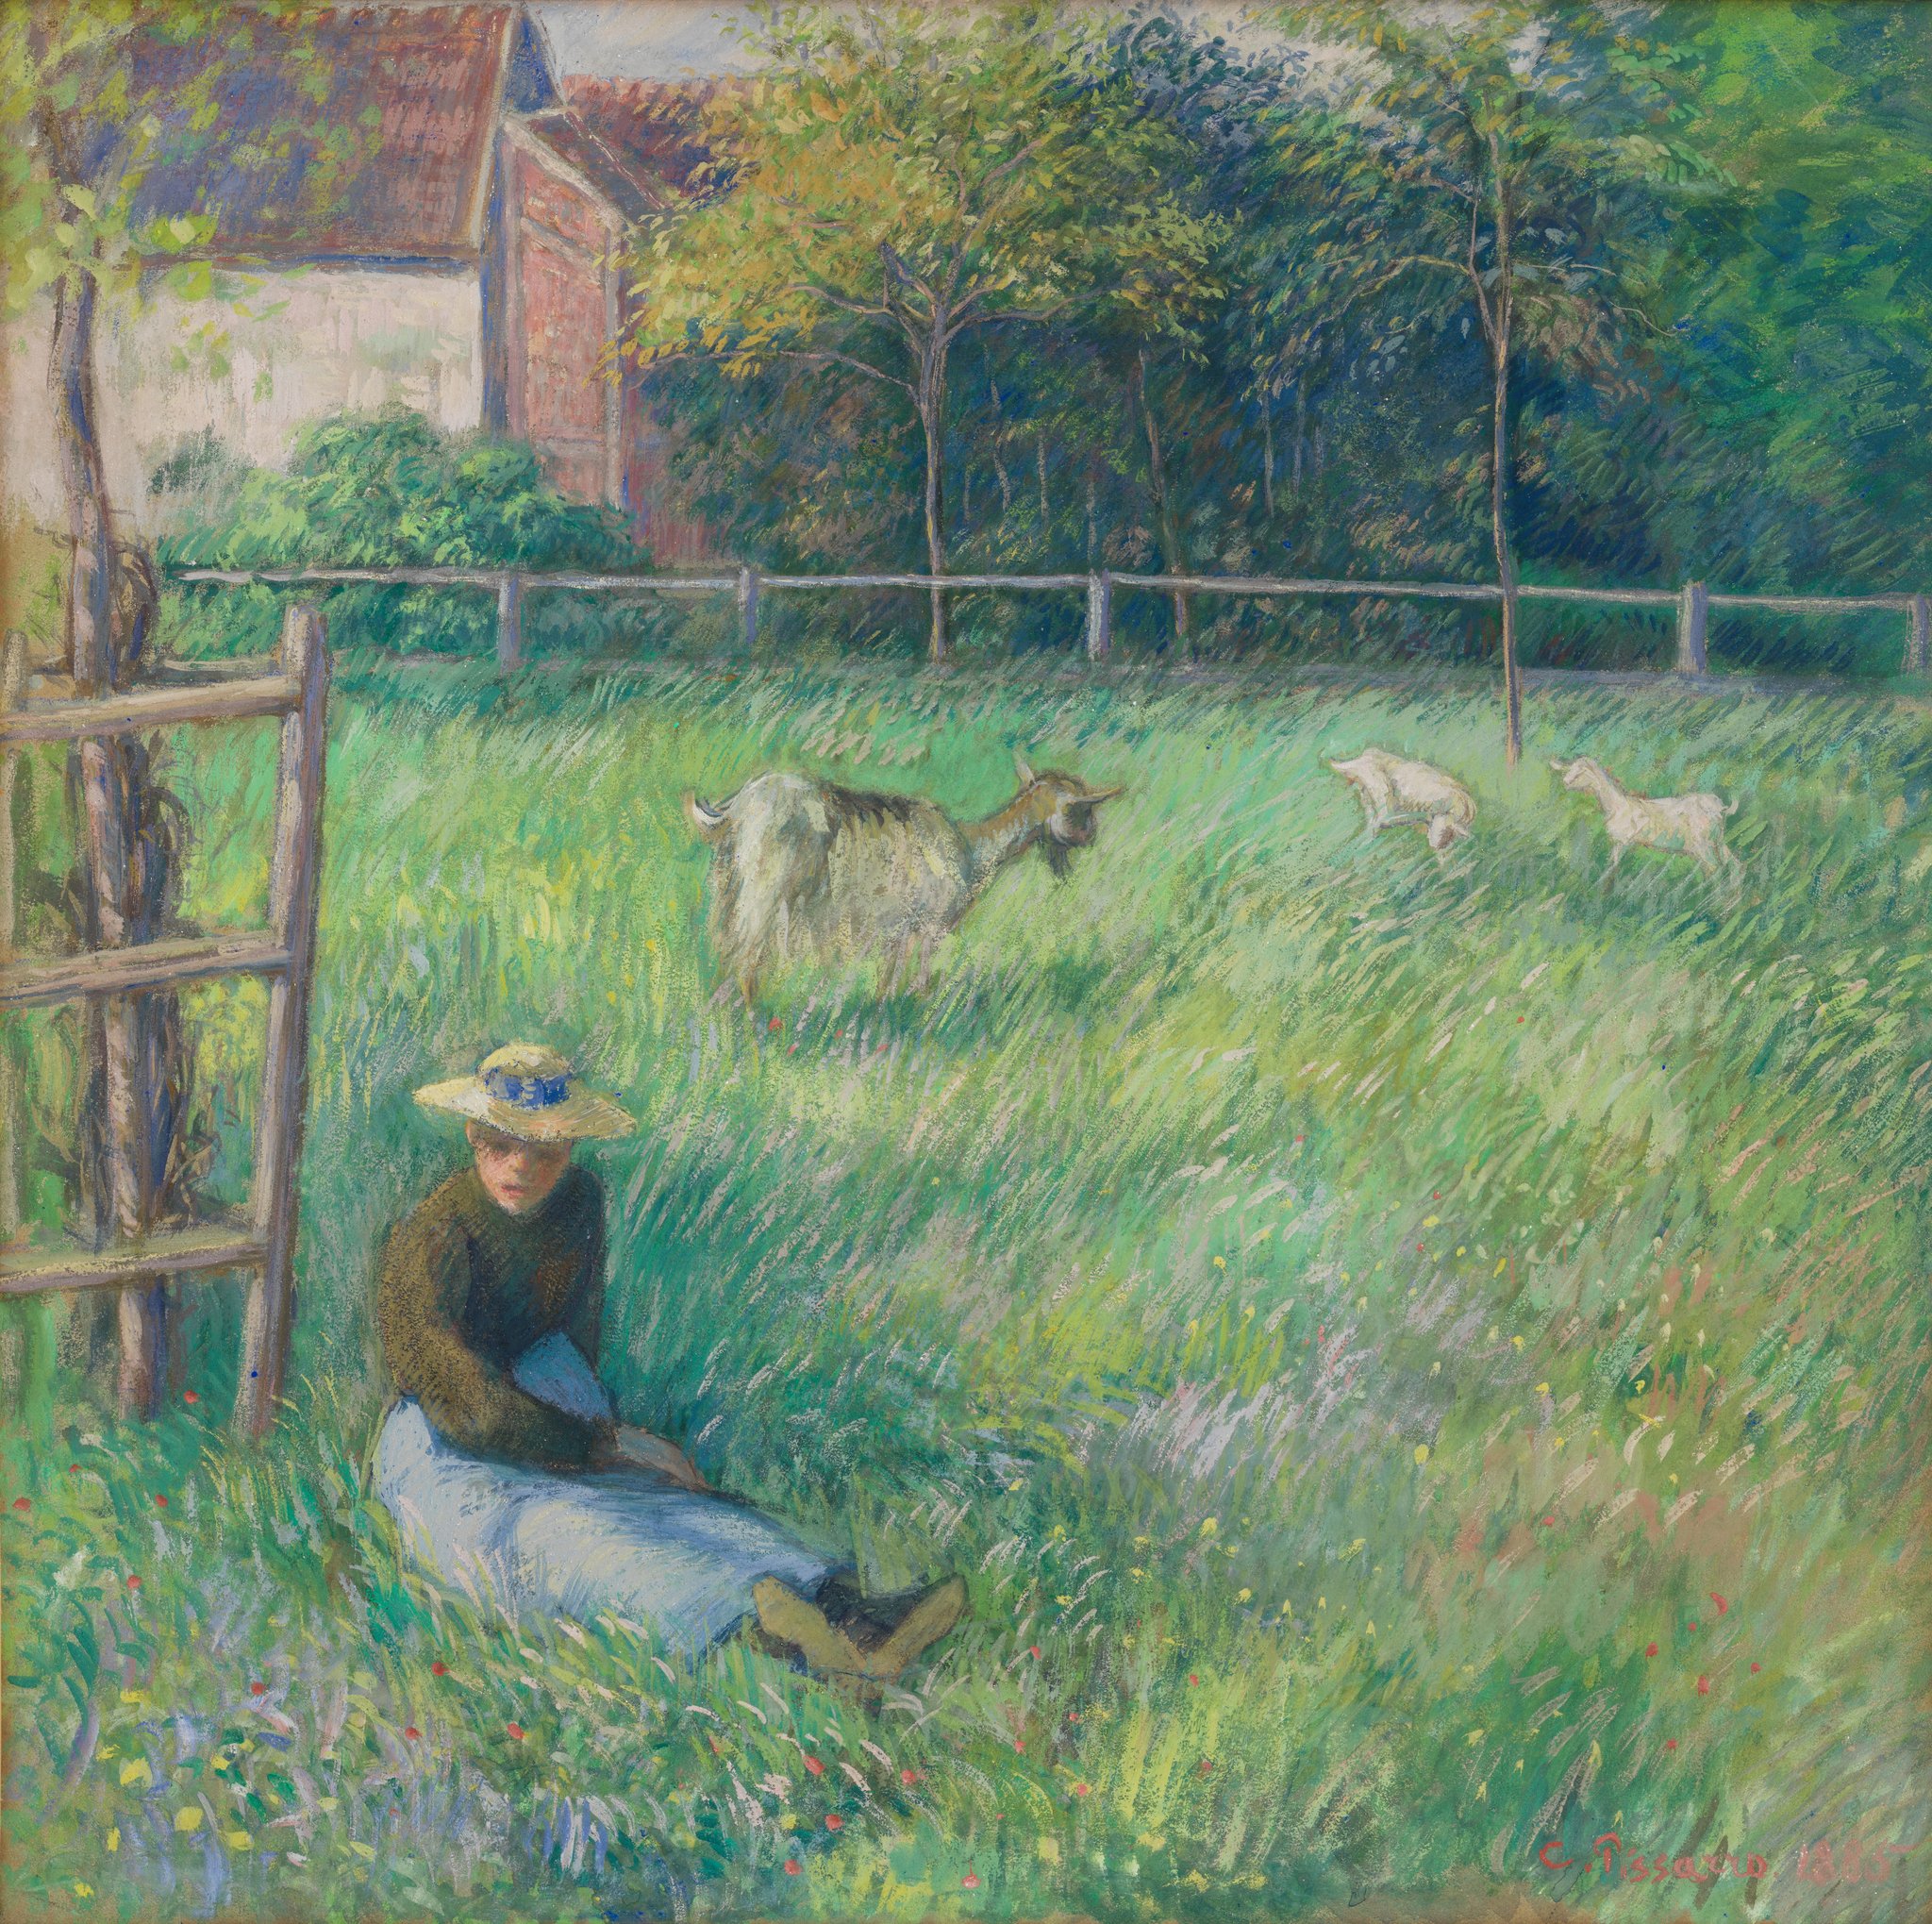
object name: drawing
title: Seated Peasant Woman with Goats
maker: camille pissarro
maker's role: artist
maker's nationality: french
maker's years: 1830-1903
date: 1885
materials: gouache, paper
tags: women,goats